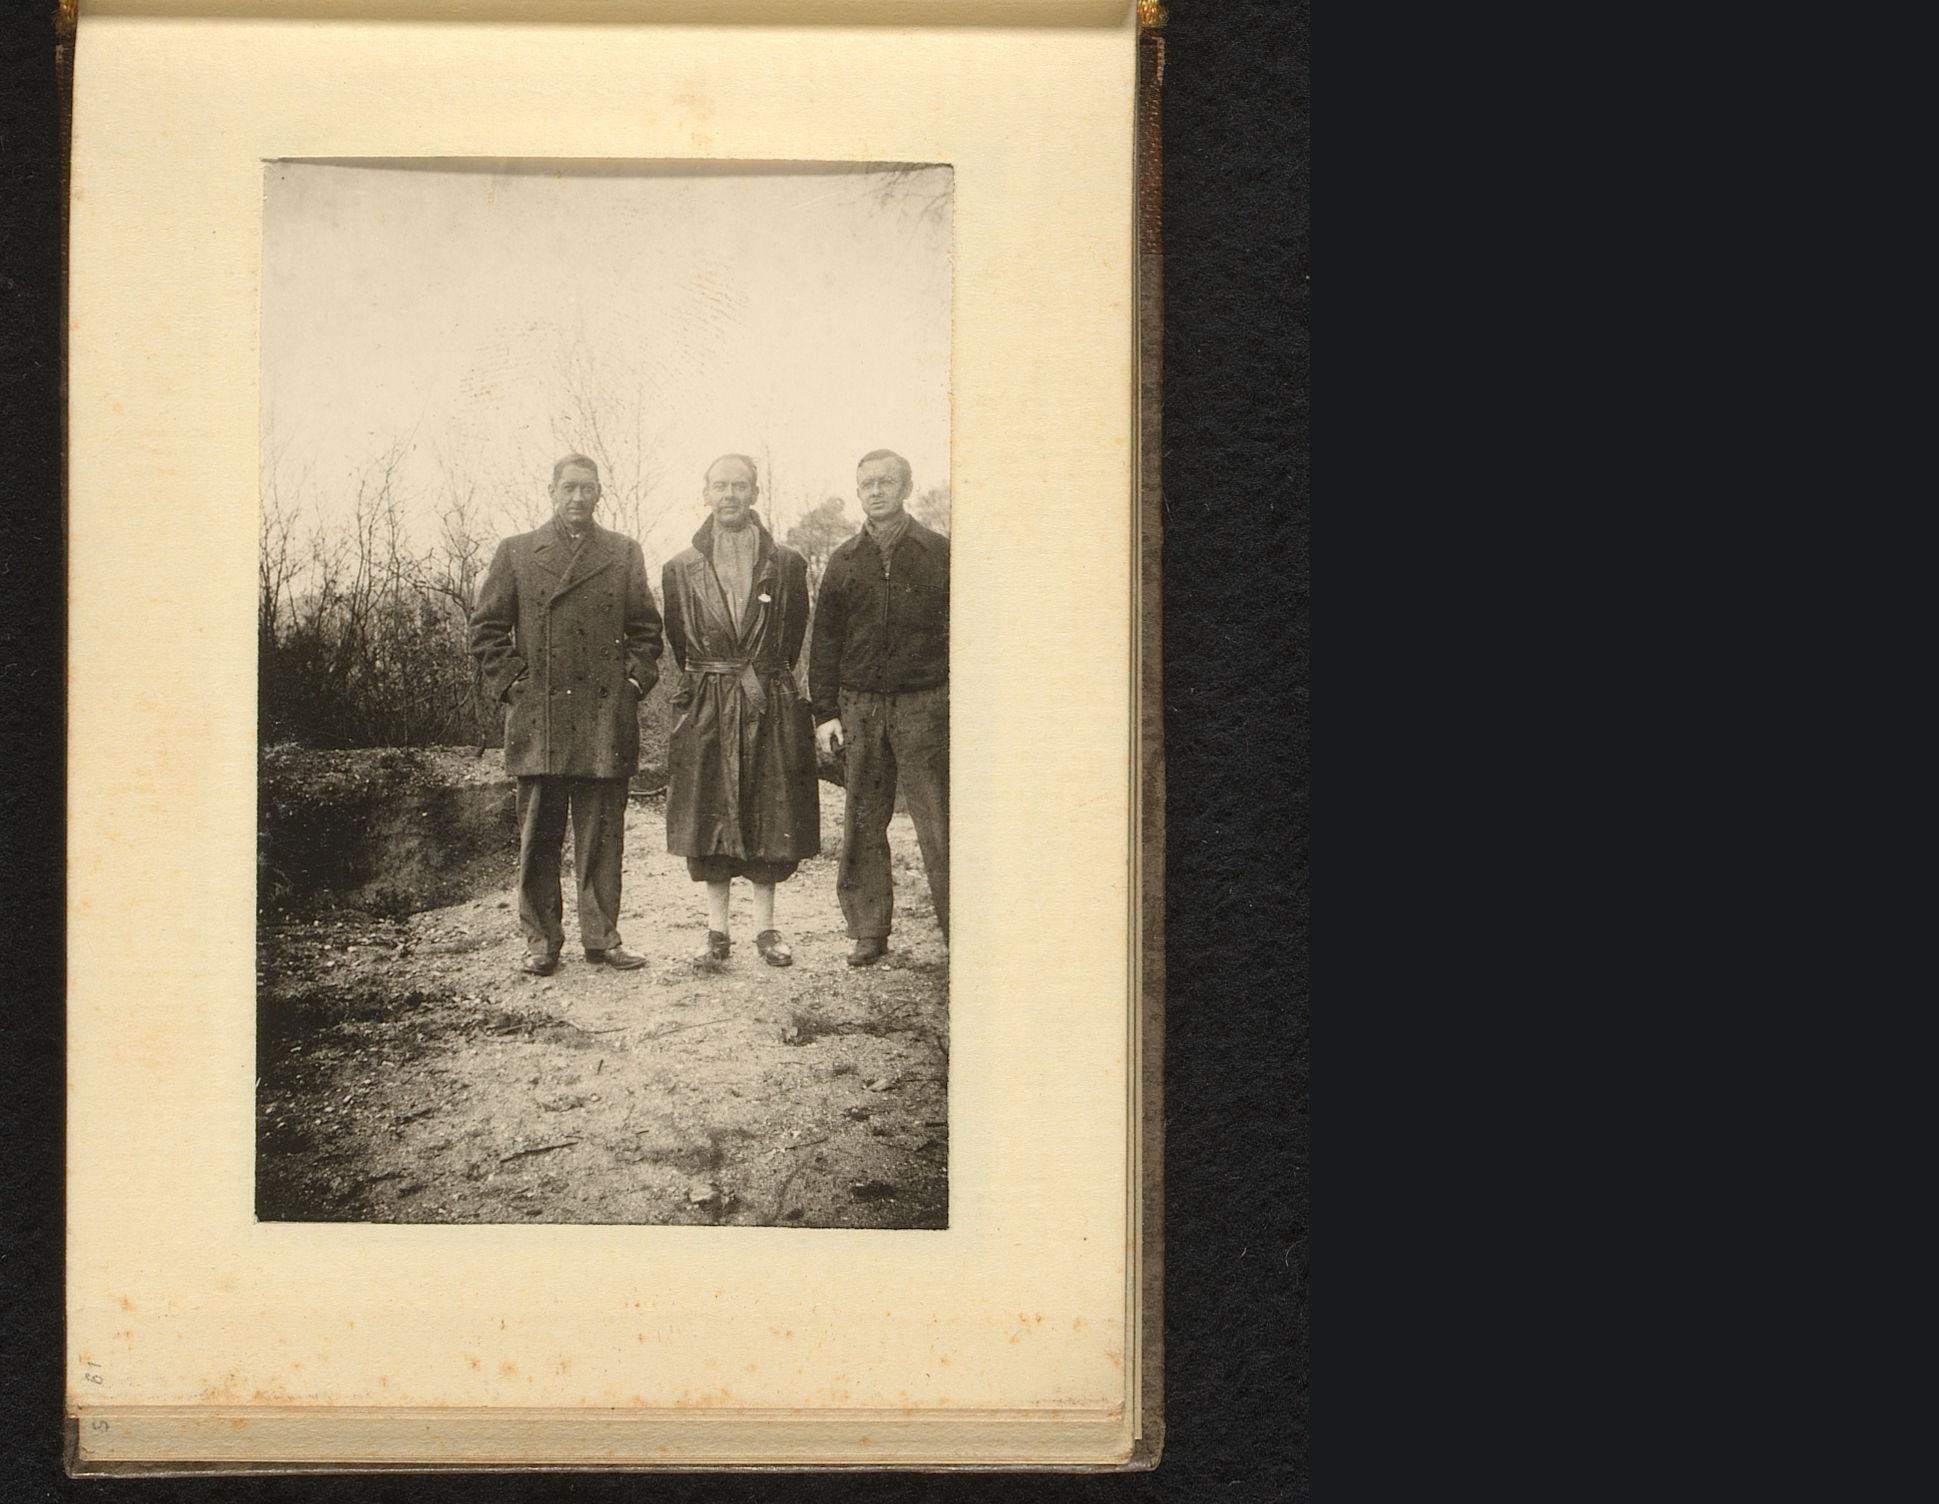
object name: photograph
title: Drie mannen in een bos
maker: norbert van den berg (1901-1972)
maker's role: amateurfotograaf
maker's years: 1901-1972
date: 1935-1950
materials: paper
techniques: gelatin silver print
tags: adult man, forest, wood